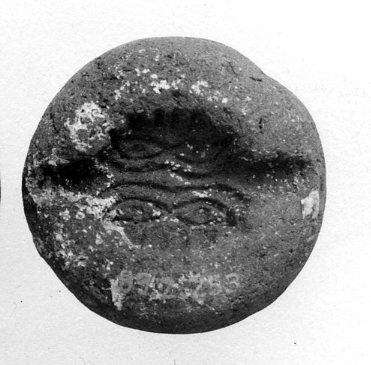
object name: mold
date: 1550-1295 BCE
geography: egypt